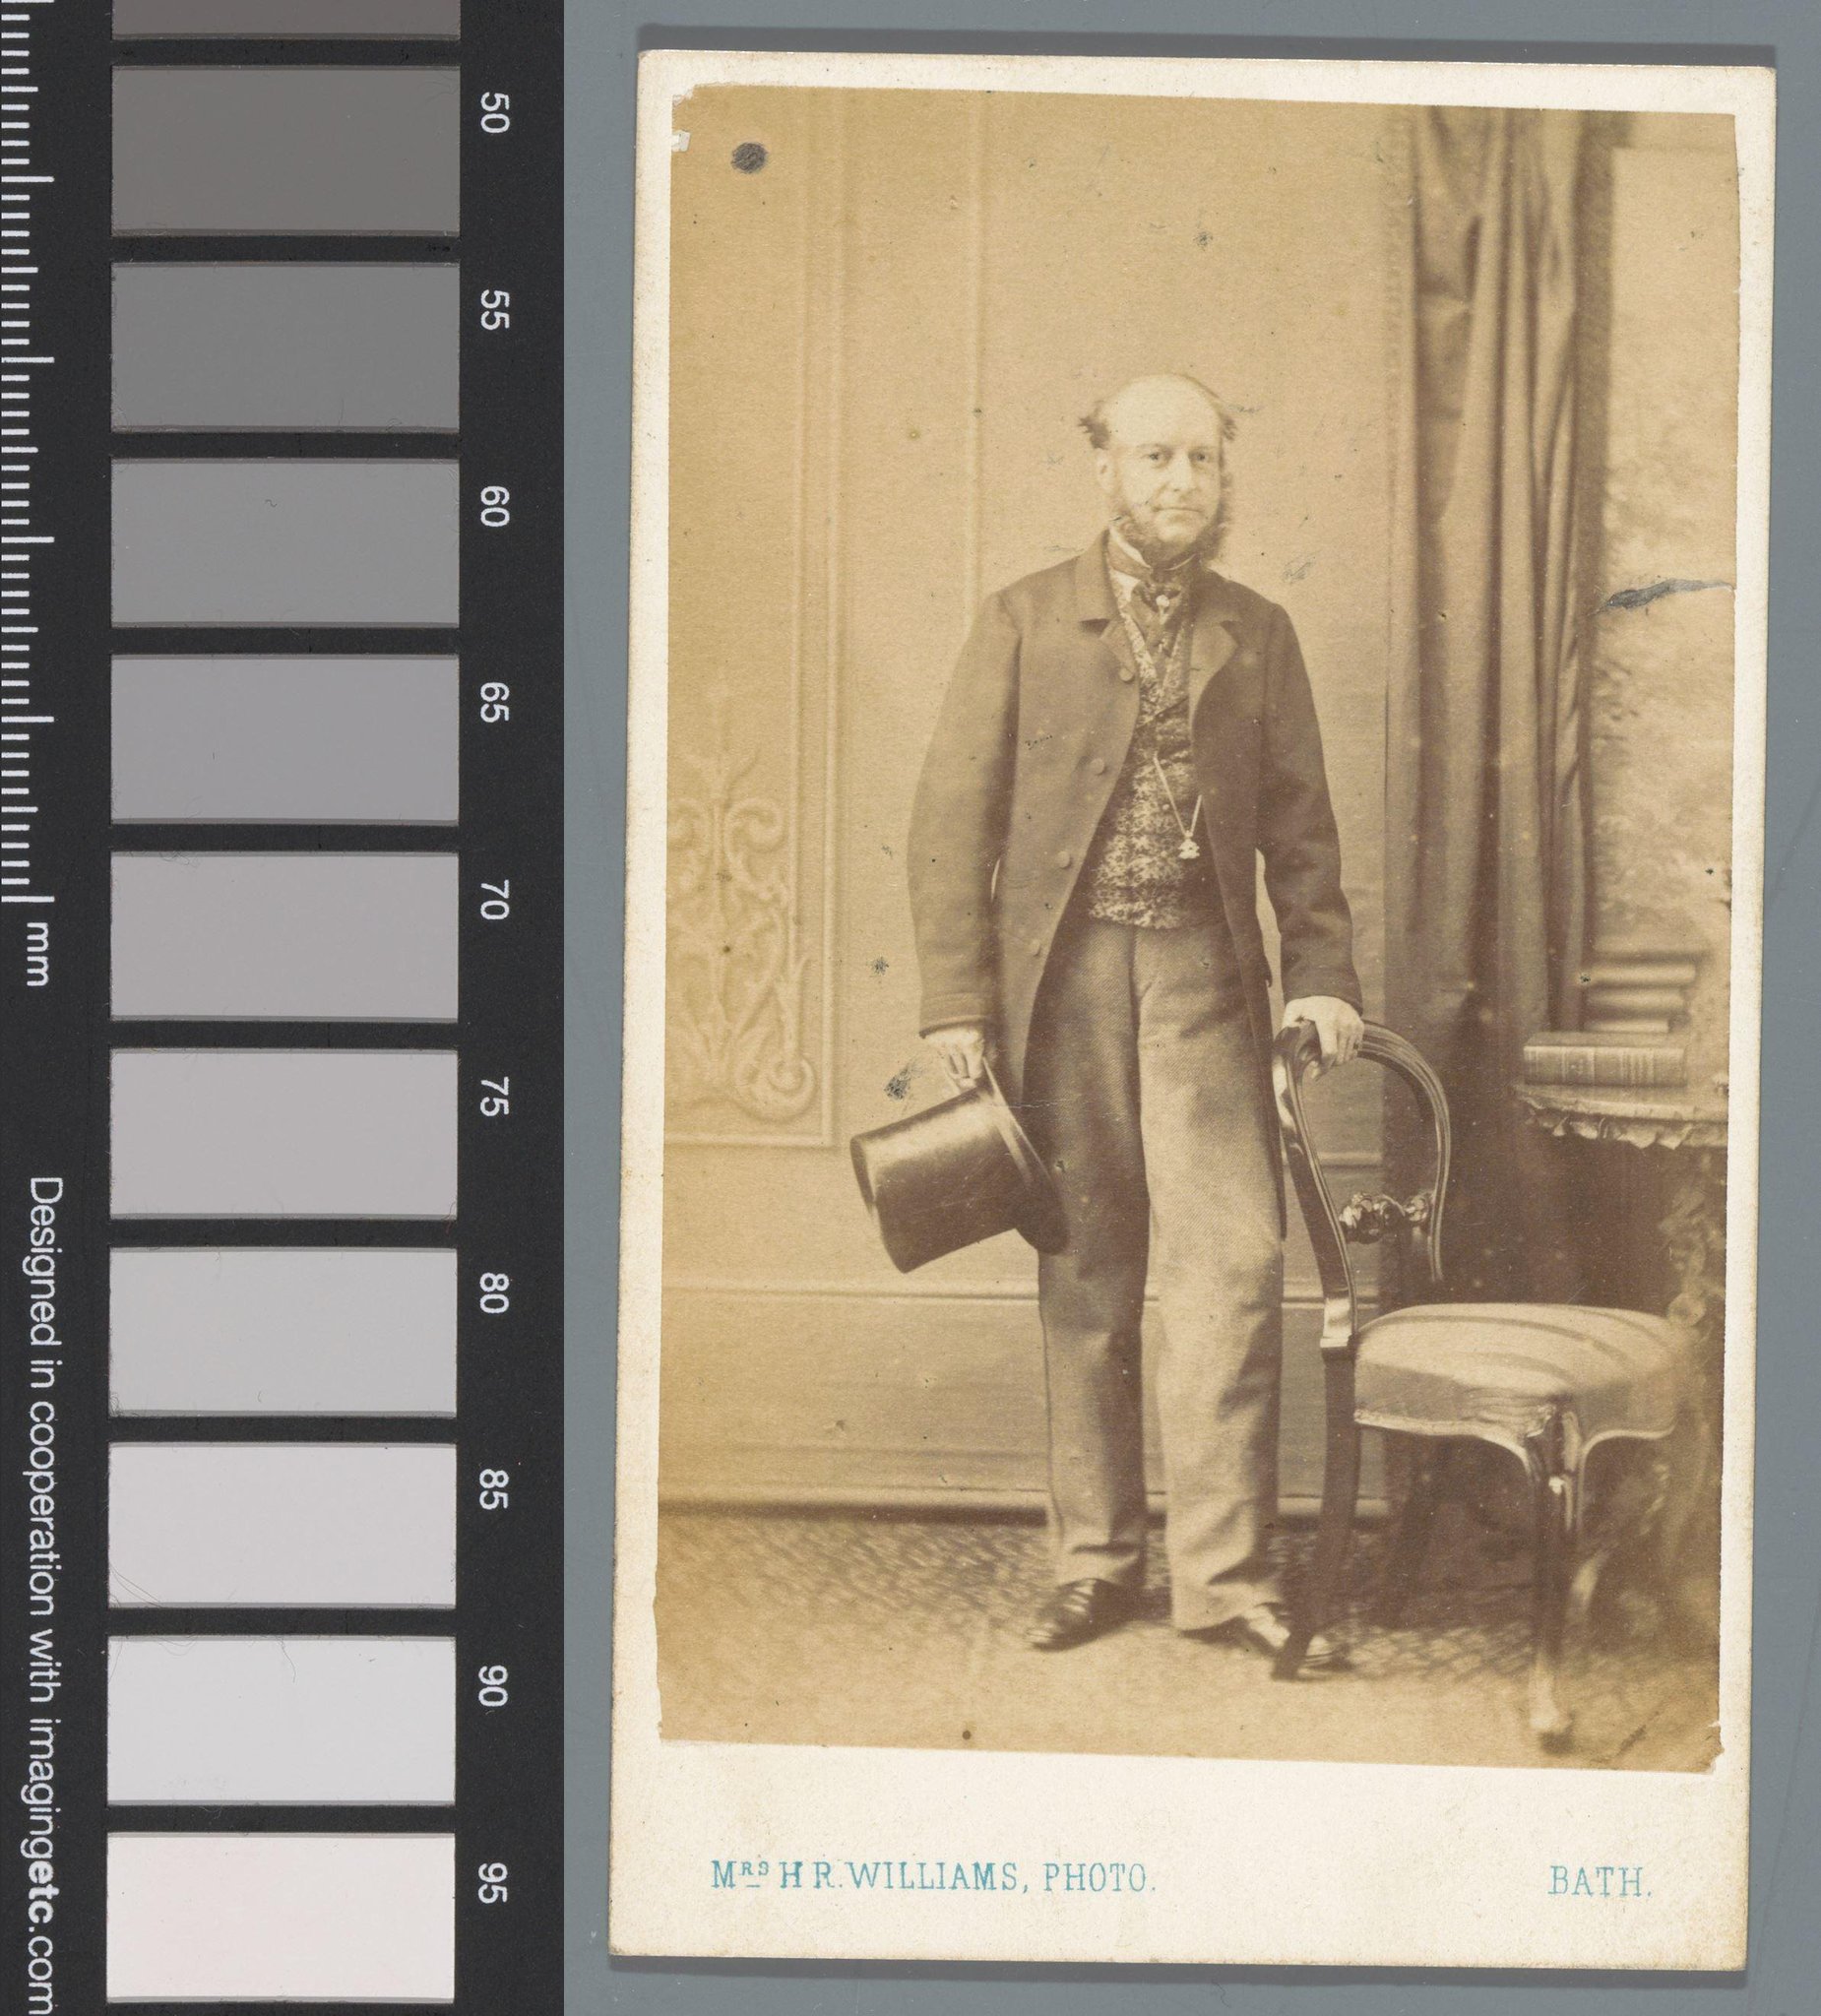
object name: photograph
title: Portret van een onbekende man met hoge hoed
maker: h.r. williams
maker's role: fotograaf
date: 1855-1885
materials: cardboard, paper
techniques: albumen print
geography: bath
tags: adult man, anonymous historical person portrayed, head-gear: top hat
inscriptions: inscription: ‘Mrs H.R. Williams, phot. Bath.’, inscription: ‘Mrs H.R. Williams/ 35, Milsom Street/ Bath.’